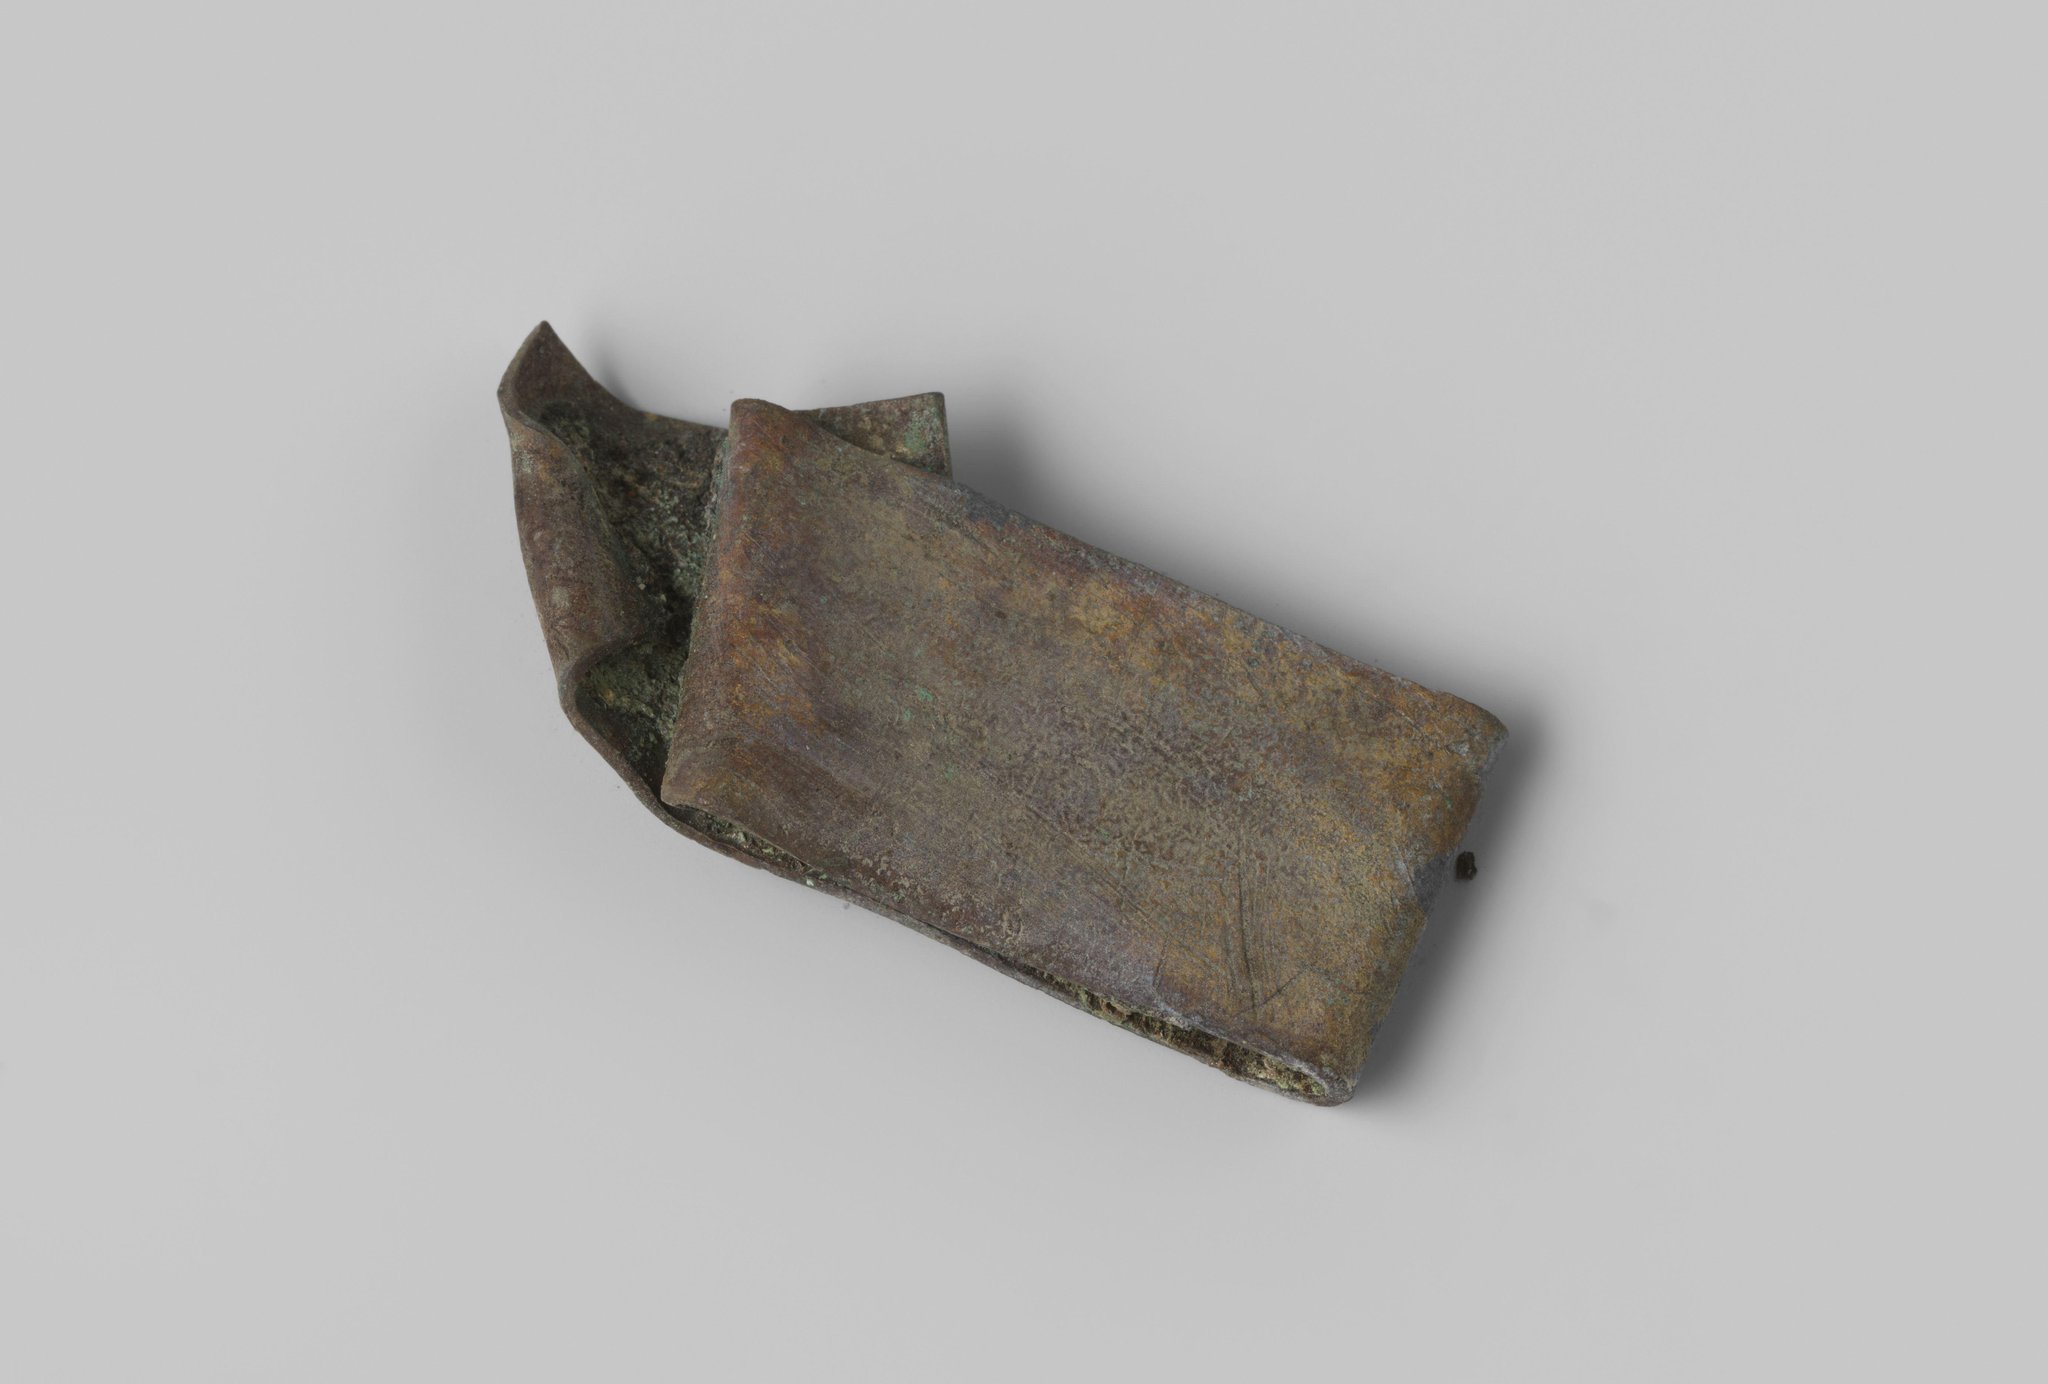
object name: firehose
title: Brandslangring uit het wrak van de Oost-Indiëvaarder Hollandia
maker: Anonymous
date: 1700-1743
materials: copper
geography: netherlands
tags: verenigde oostindische compagnie, hollandia (schip), annet